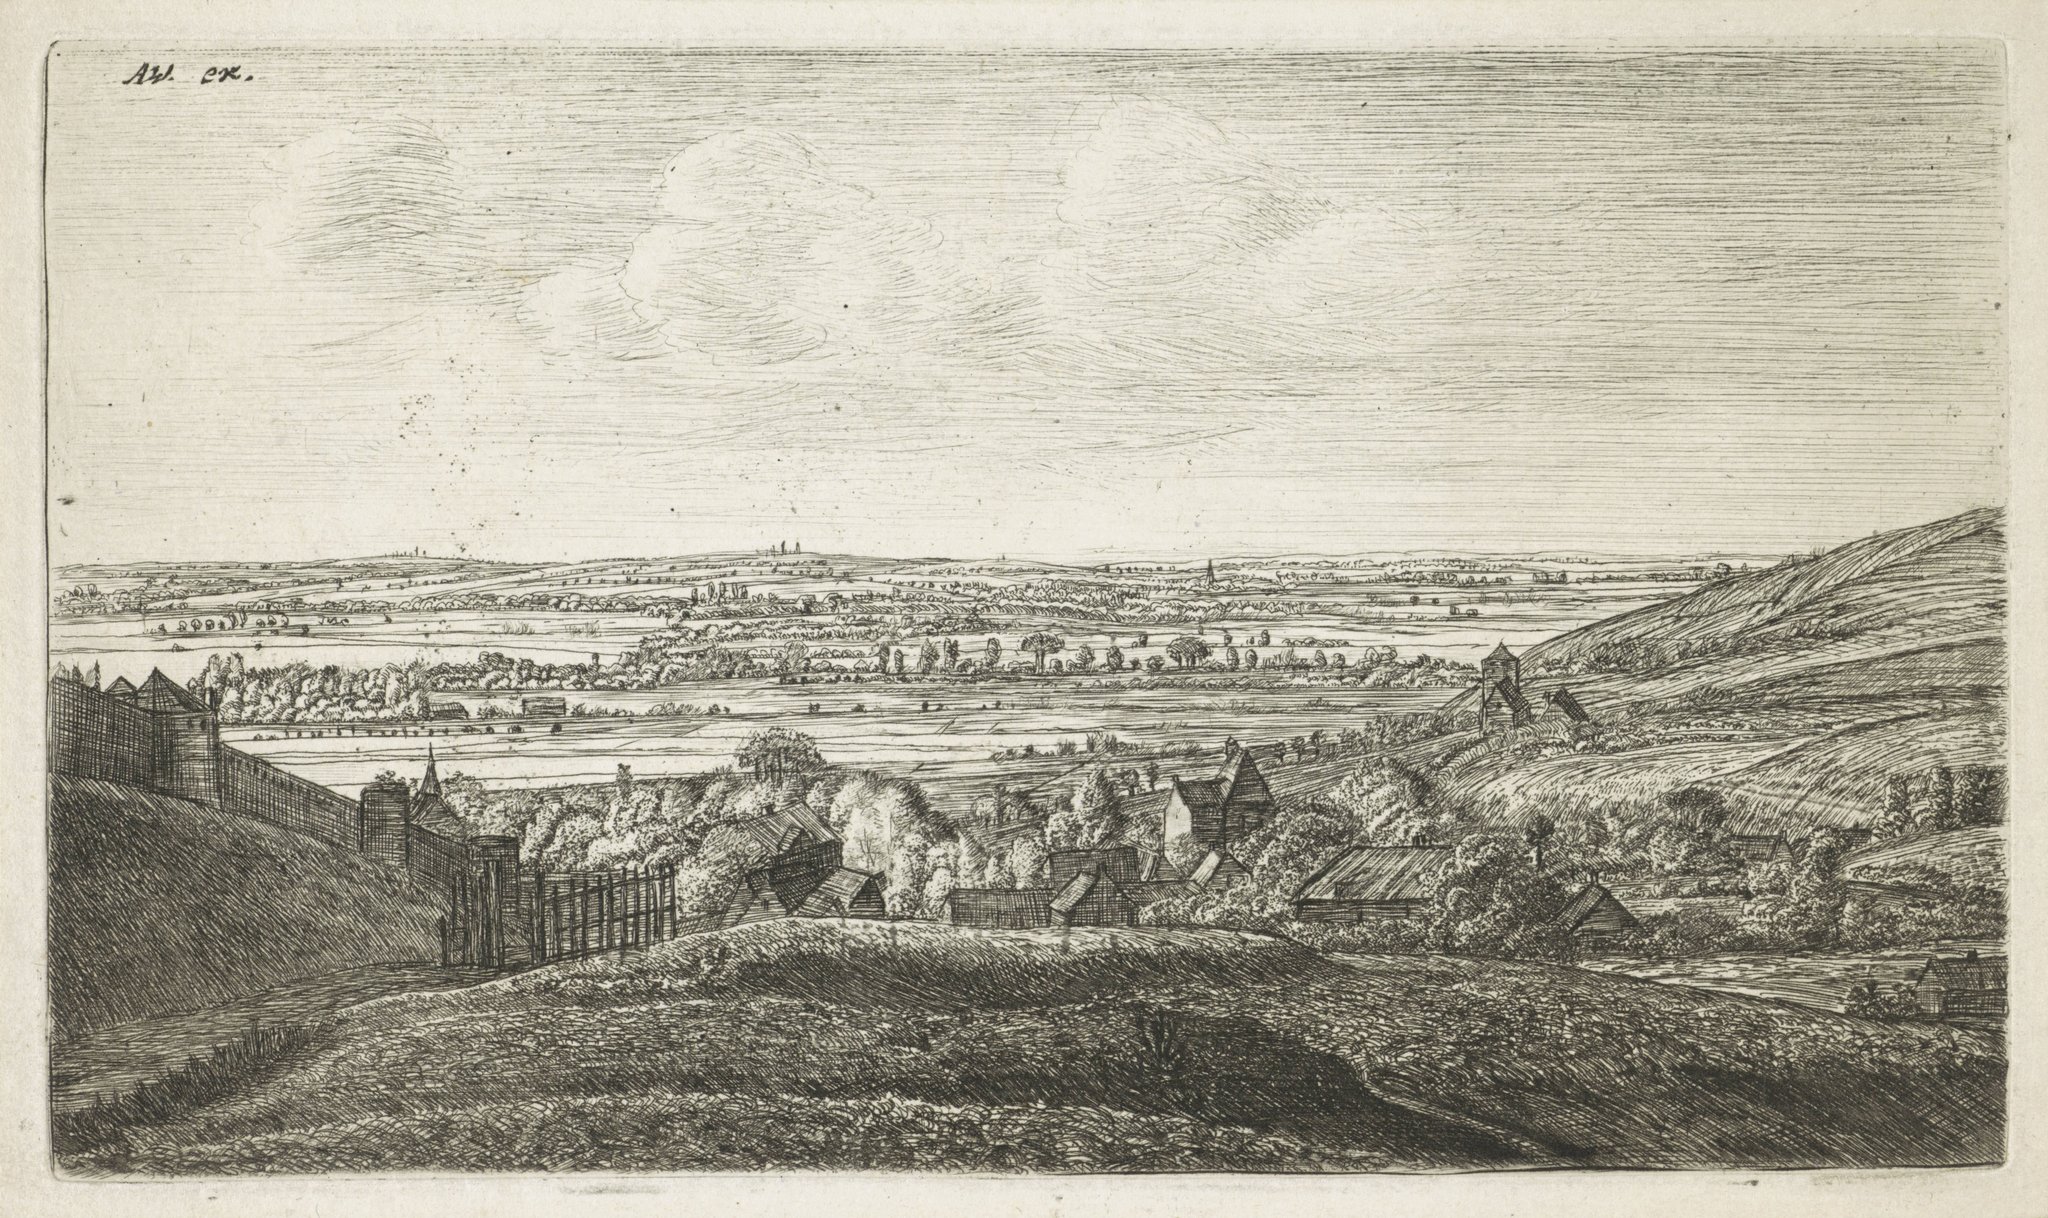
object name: print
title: Dorp in een vallei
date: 1630-1663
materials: paper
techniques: etching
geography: amsterdam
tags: low hill country, watermill in landscape, rhenen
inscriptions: collector's mark: Lugt 2233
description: Waterloo heeft deze staat niet uitgegeven. Zie Hollstein voor een volledig overzicht van de verschillende edities.